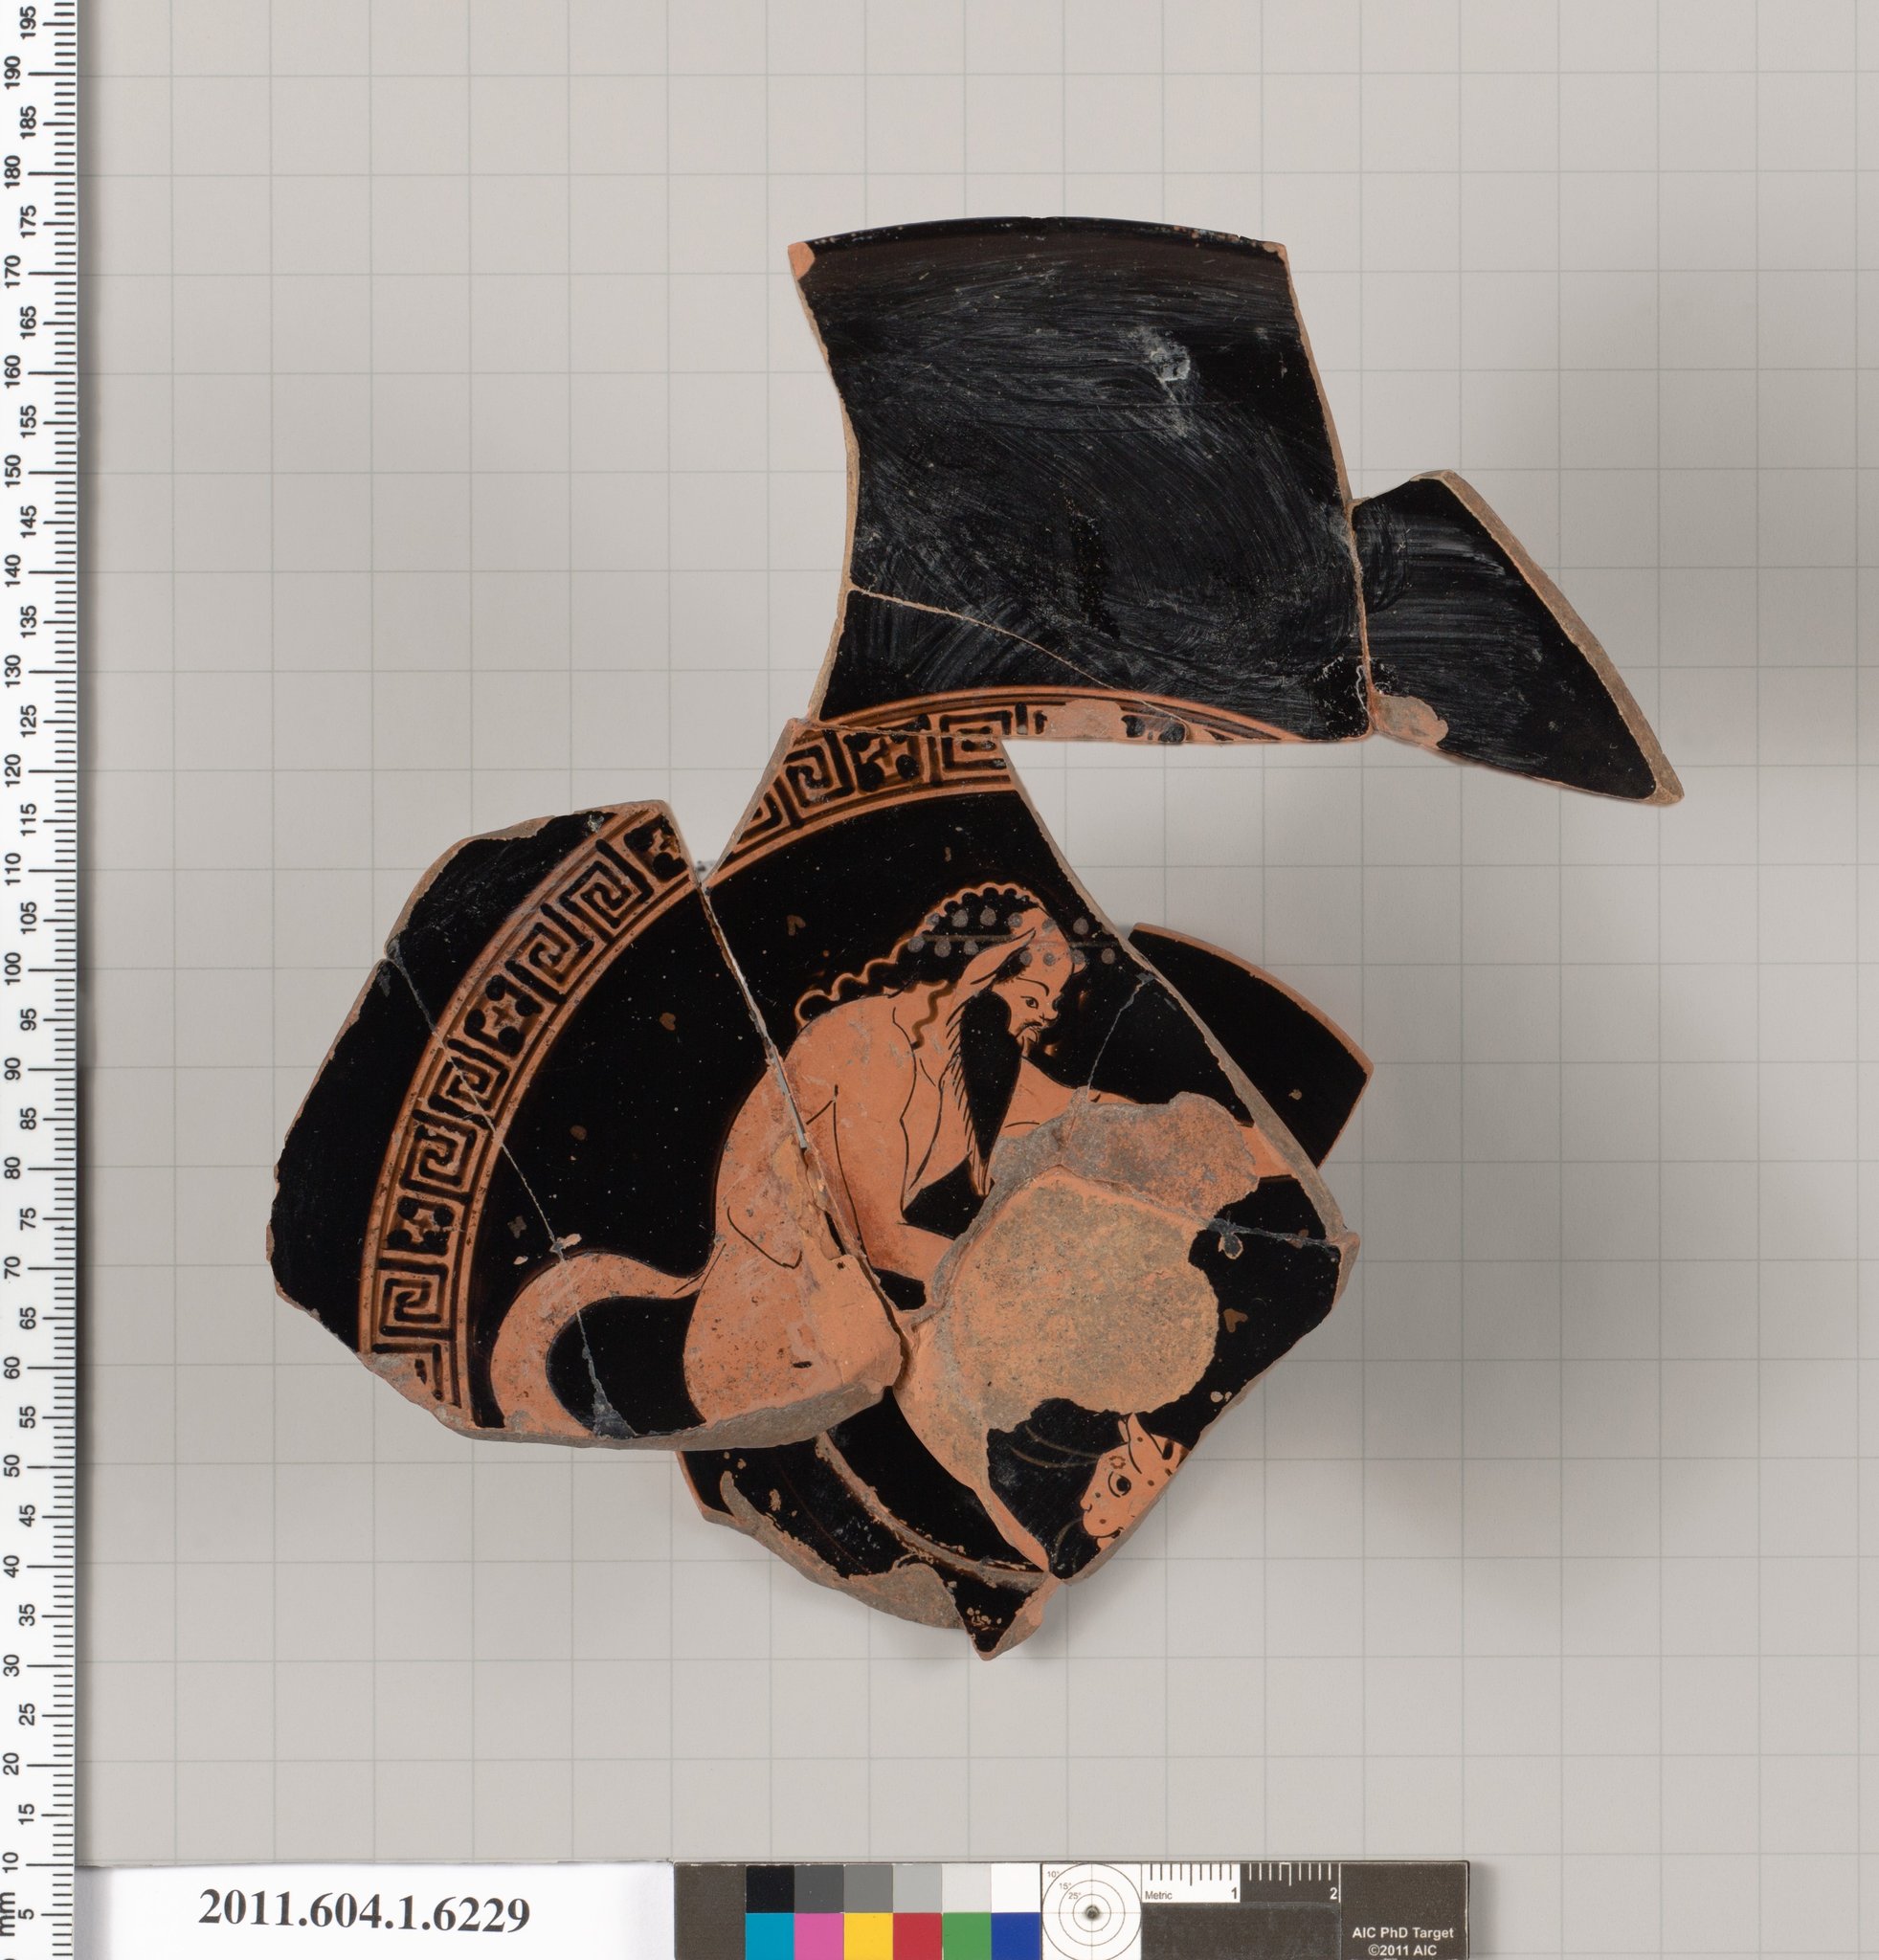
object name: kylix fragment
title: Terracotta fragment of a kylix (drinking cup)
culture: greek, attic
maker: eucharides painter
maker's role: artist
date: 490 BCE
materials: terracotta